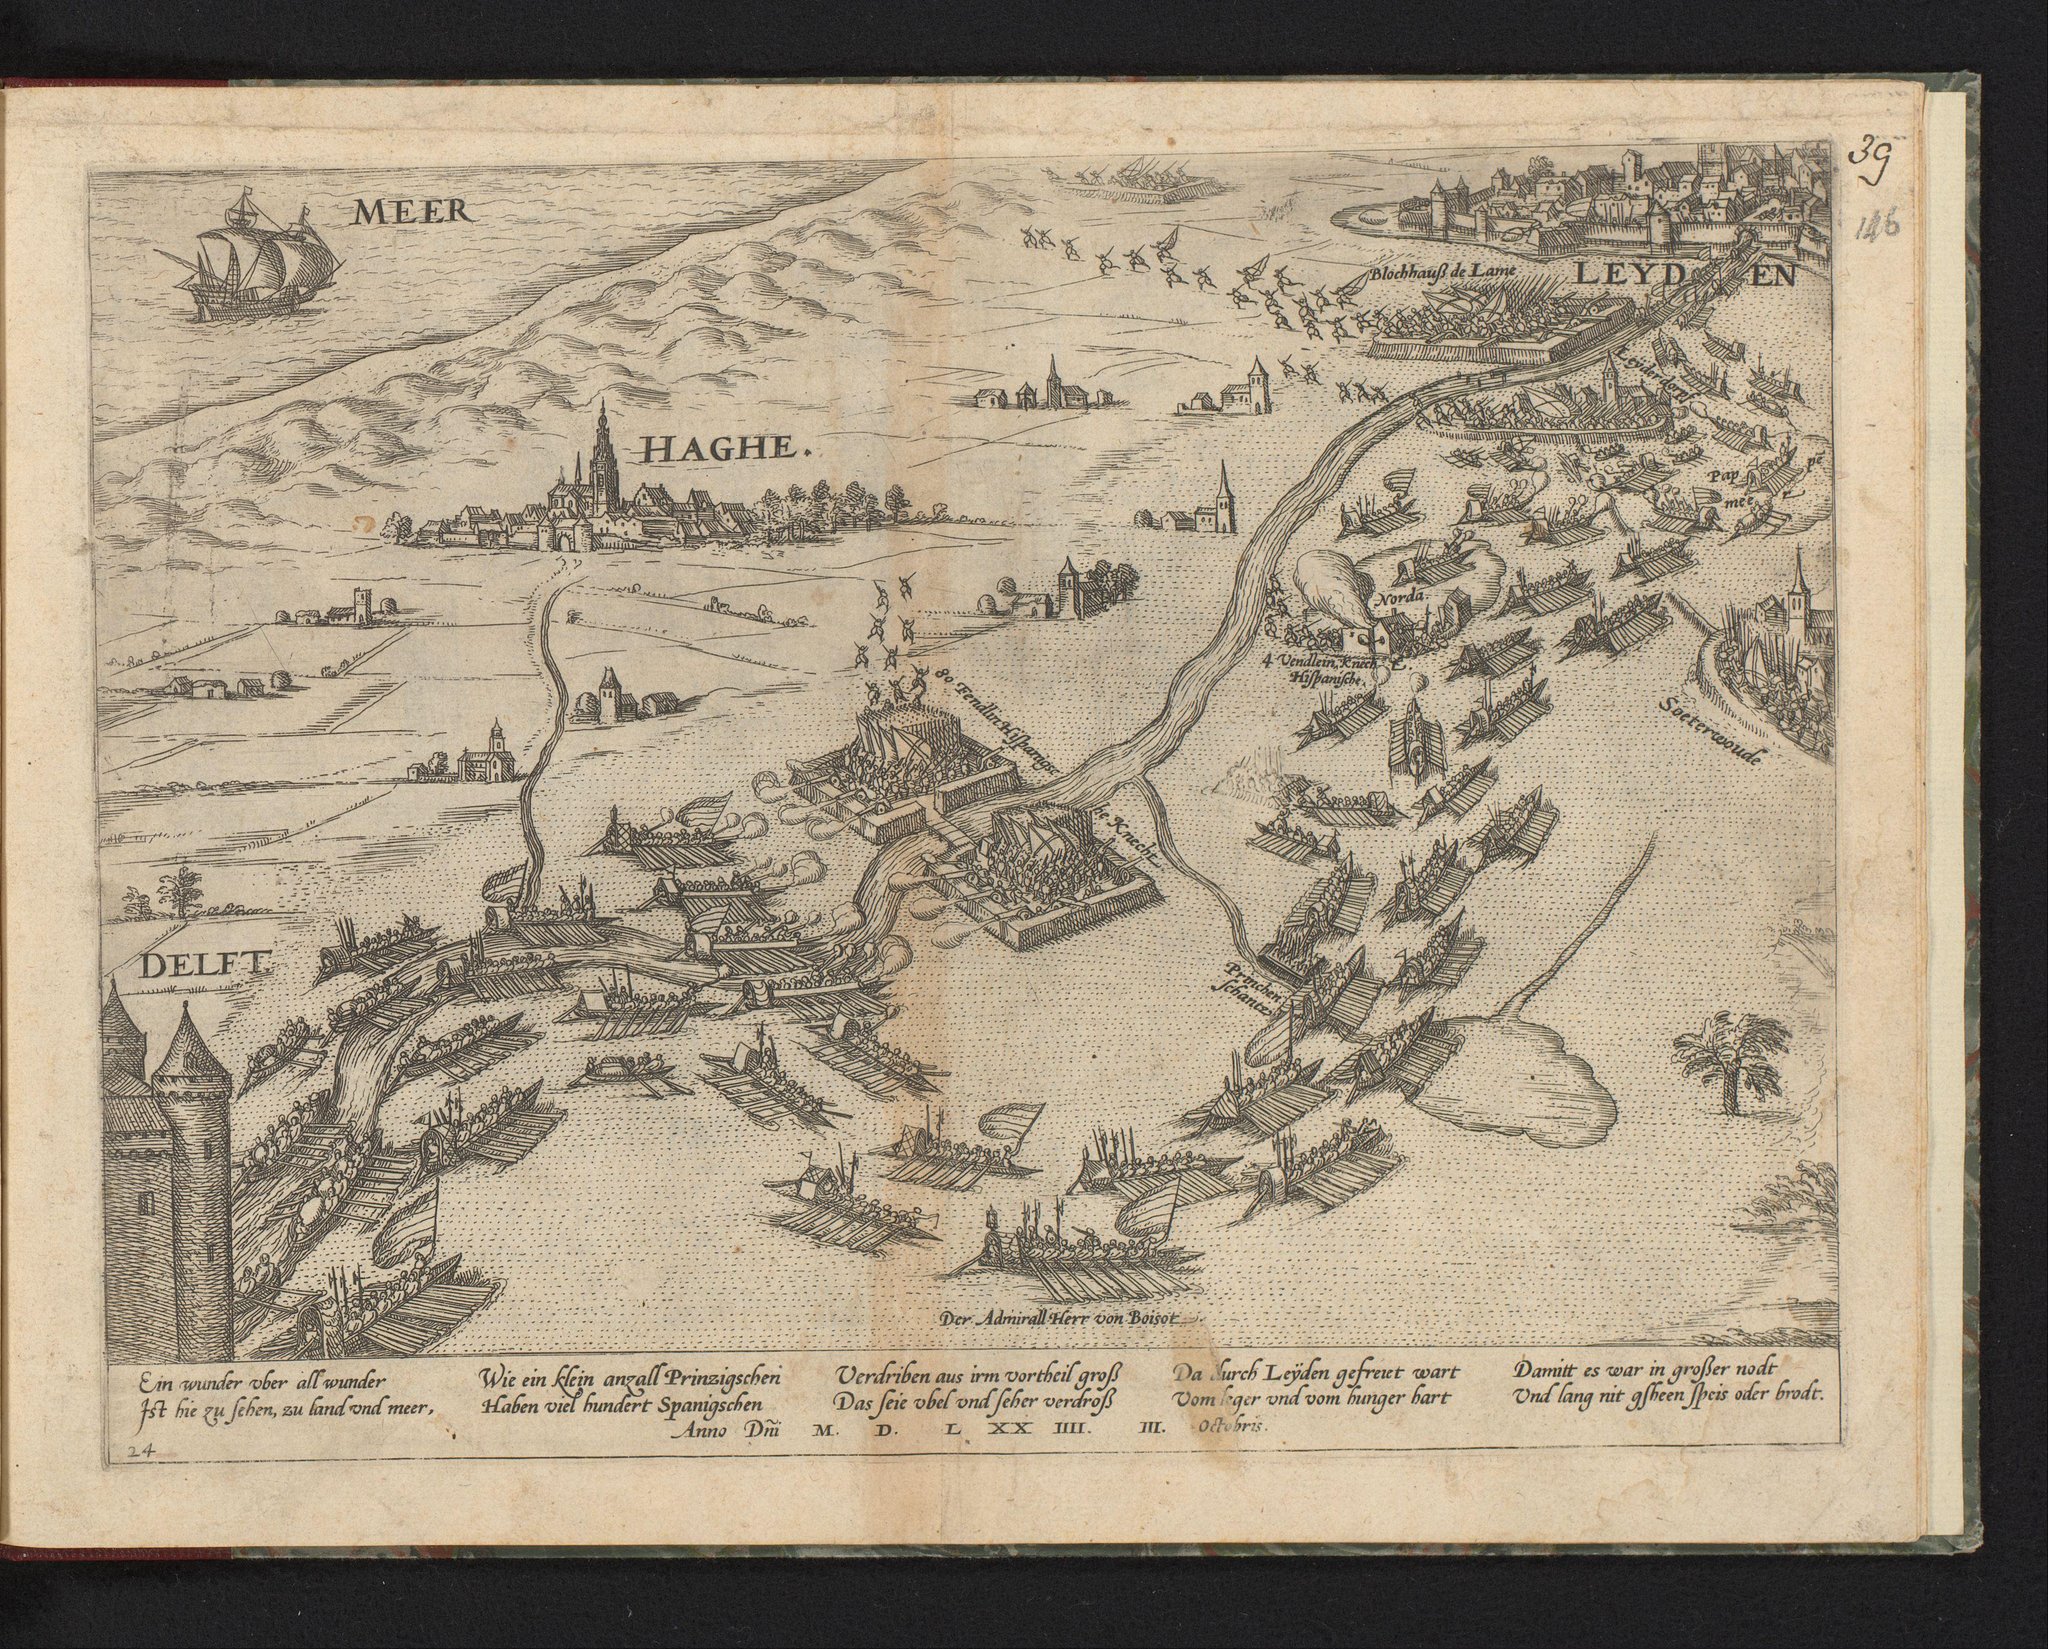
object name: album leaf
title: Ontzet van Leiden, 1574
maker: frans hogenberg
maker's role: print maker, publisher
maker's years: 1538-1590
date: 1574-1576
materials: paper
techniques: etching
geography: cologne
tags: brussels, raising the siege with outside assistance, relief, leiden, the hague, delft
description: Het ontzet van Leiden op 3 oktober 1574. Troepen van de prins varen over de ondergelopen polders van Delft langs Den Haag naar Leiden, onder bevel van admiraal Louis de Boisot. Spaanse belegeraars vluchten vanuit hun stellingen. Met onderschrift van 10 regels in het Duits. Genummerd: 24. De prent maakt deel uit van een album.